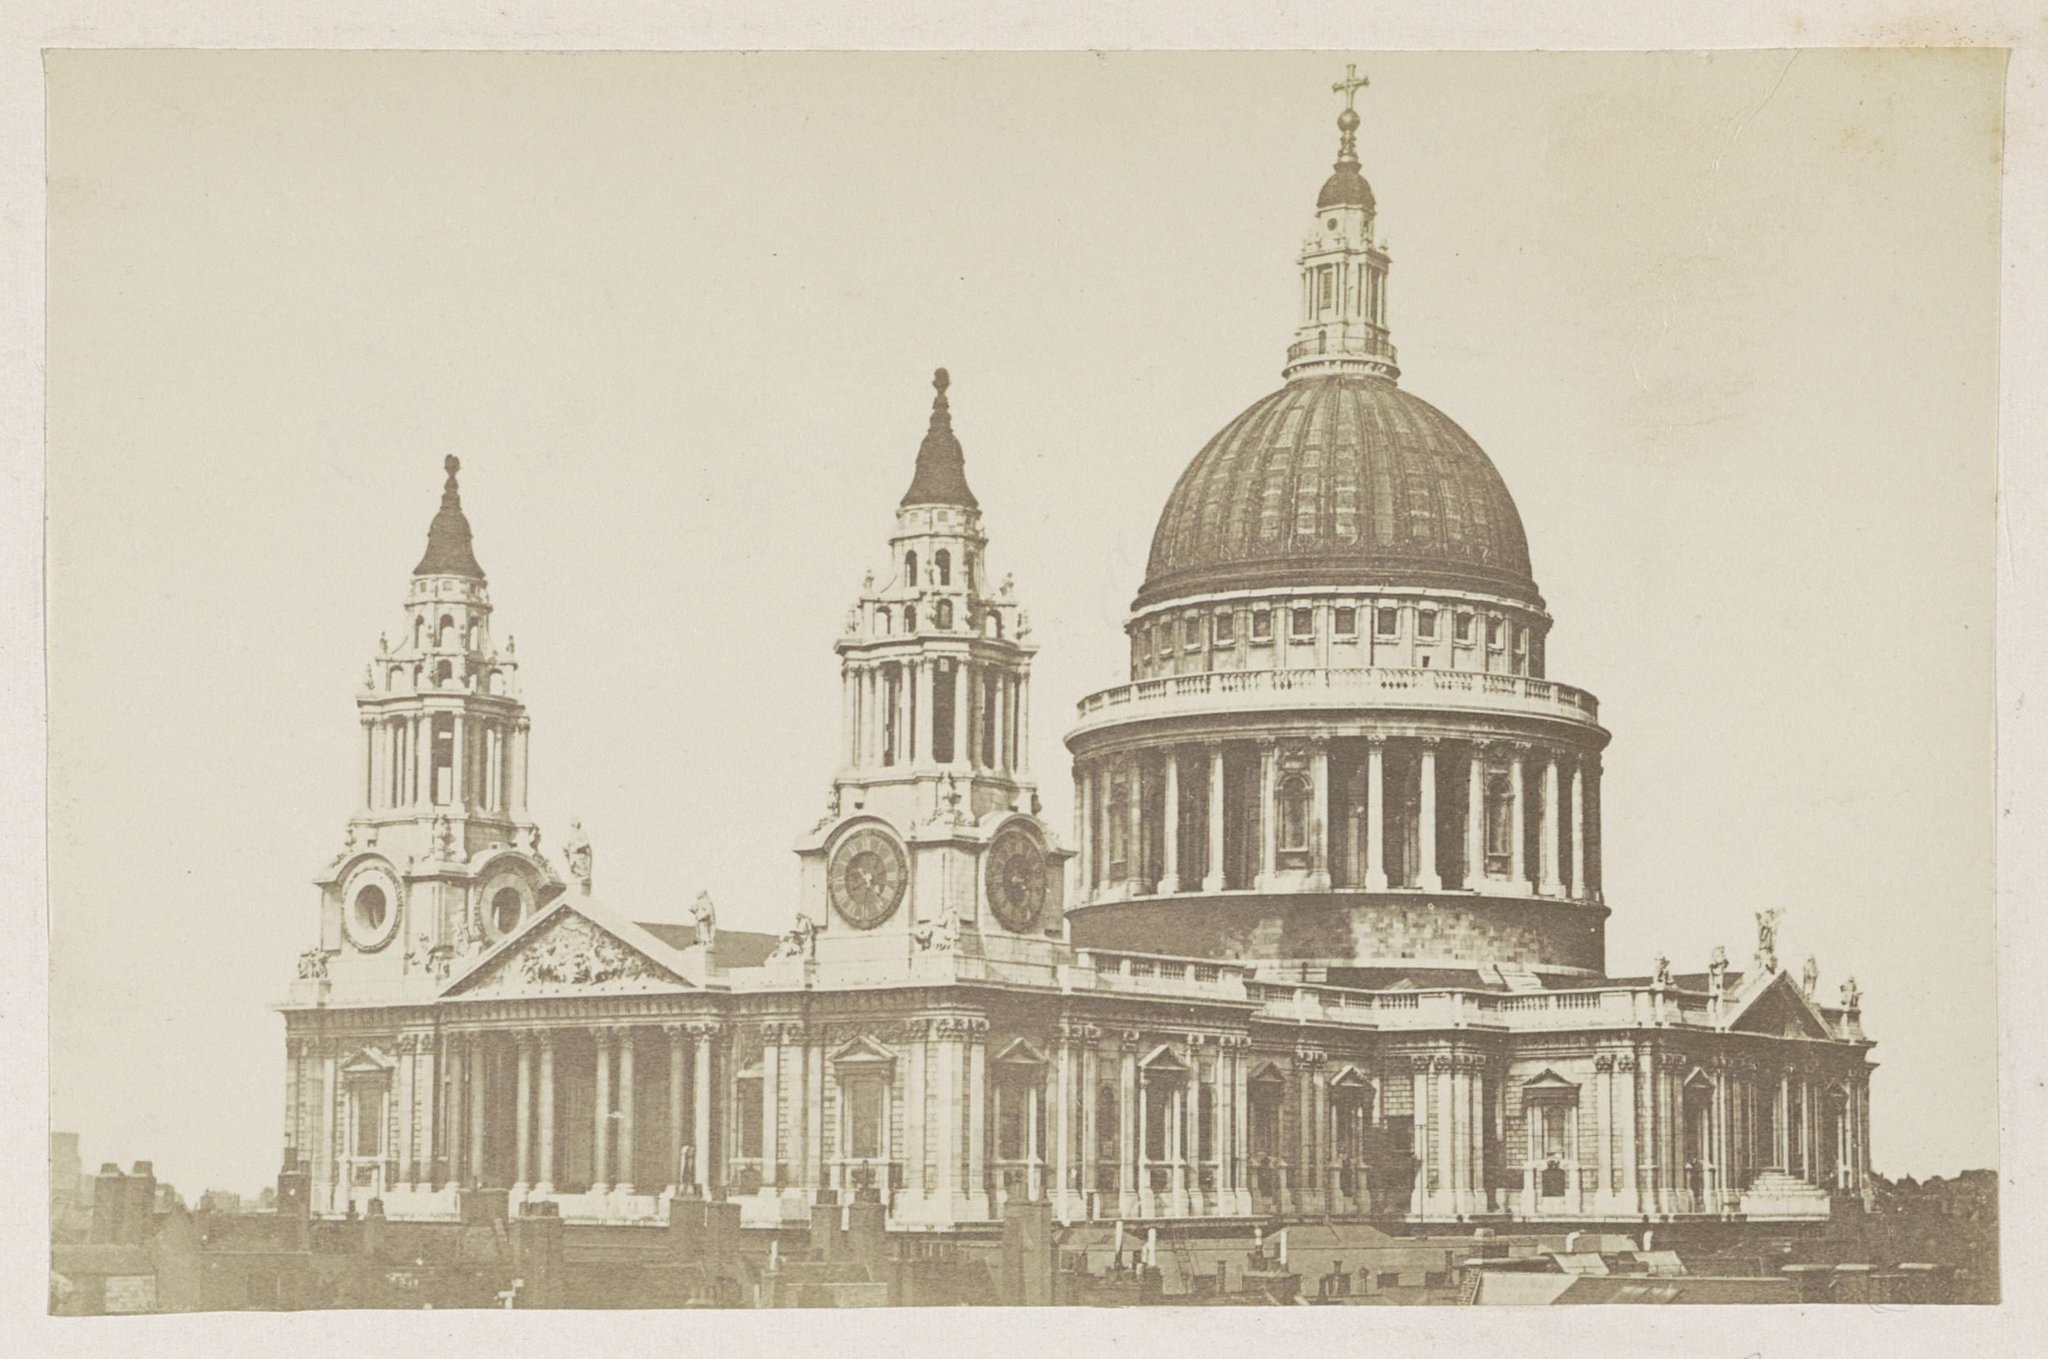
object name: photograph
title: Exterieur van St Paul's Cathedral in Londen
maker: francis godolphin osbourne stuart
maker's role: fotograaf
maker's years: 1843-1923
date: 1878-1890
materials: photographic support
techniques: albumen print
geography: london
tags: protestant churches and denominations, exterior ~ representation of a building, london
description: Onderdeel van Reisalbum Europese steden, vermoedelijk Zweeds.